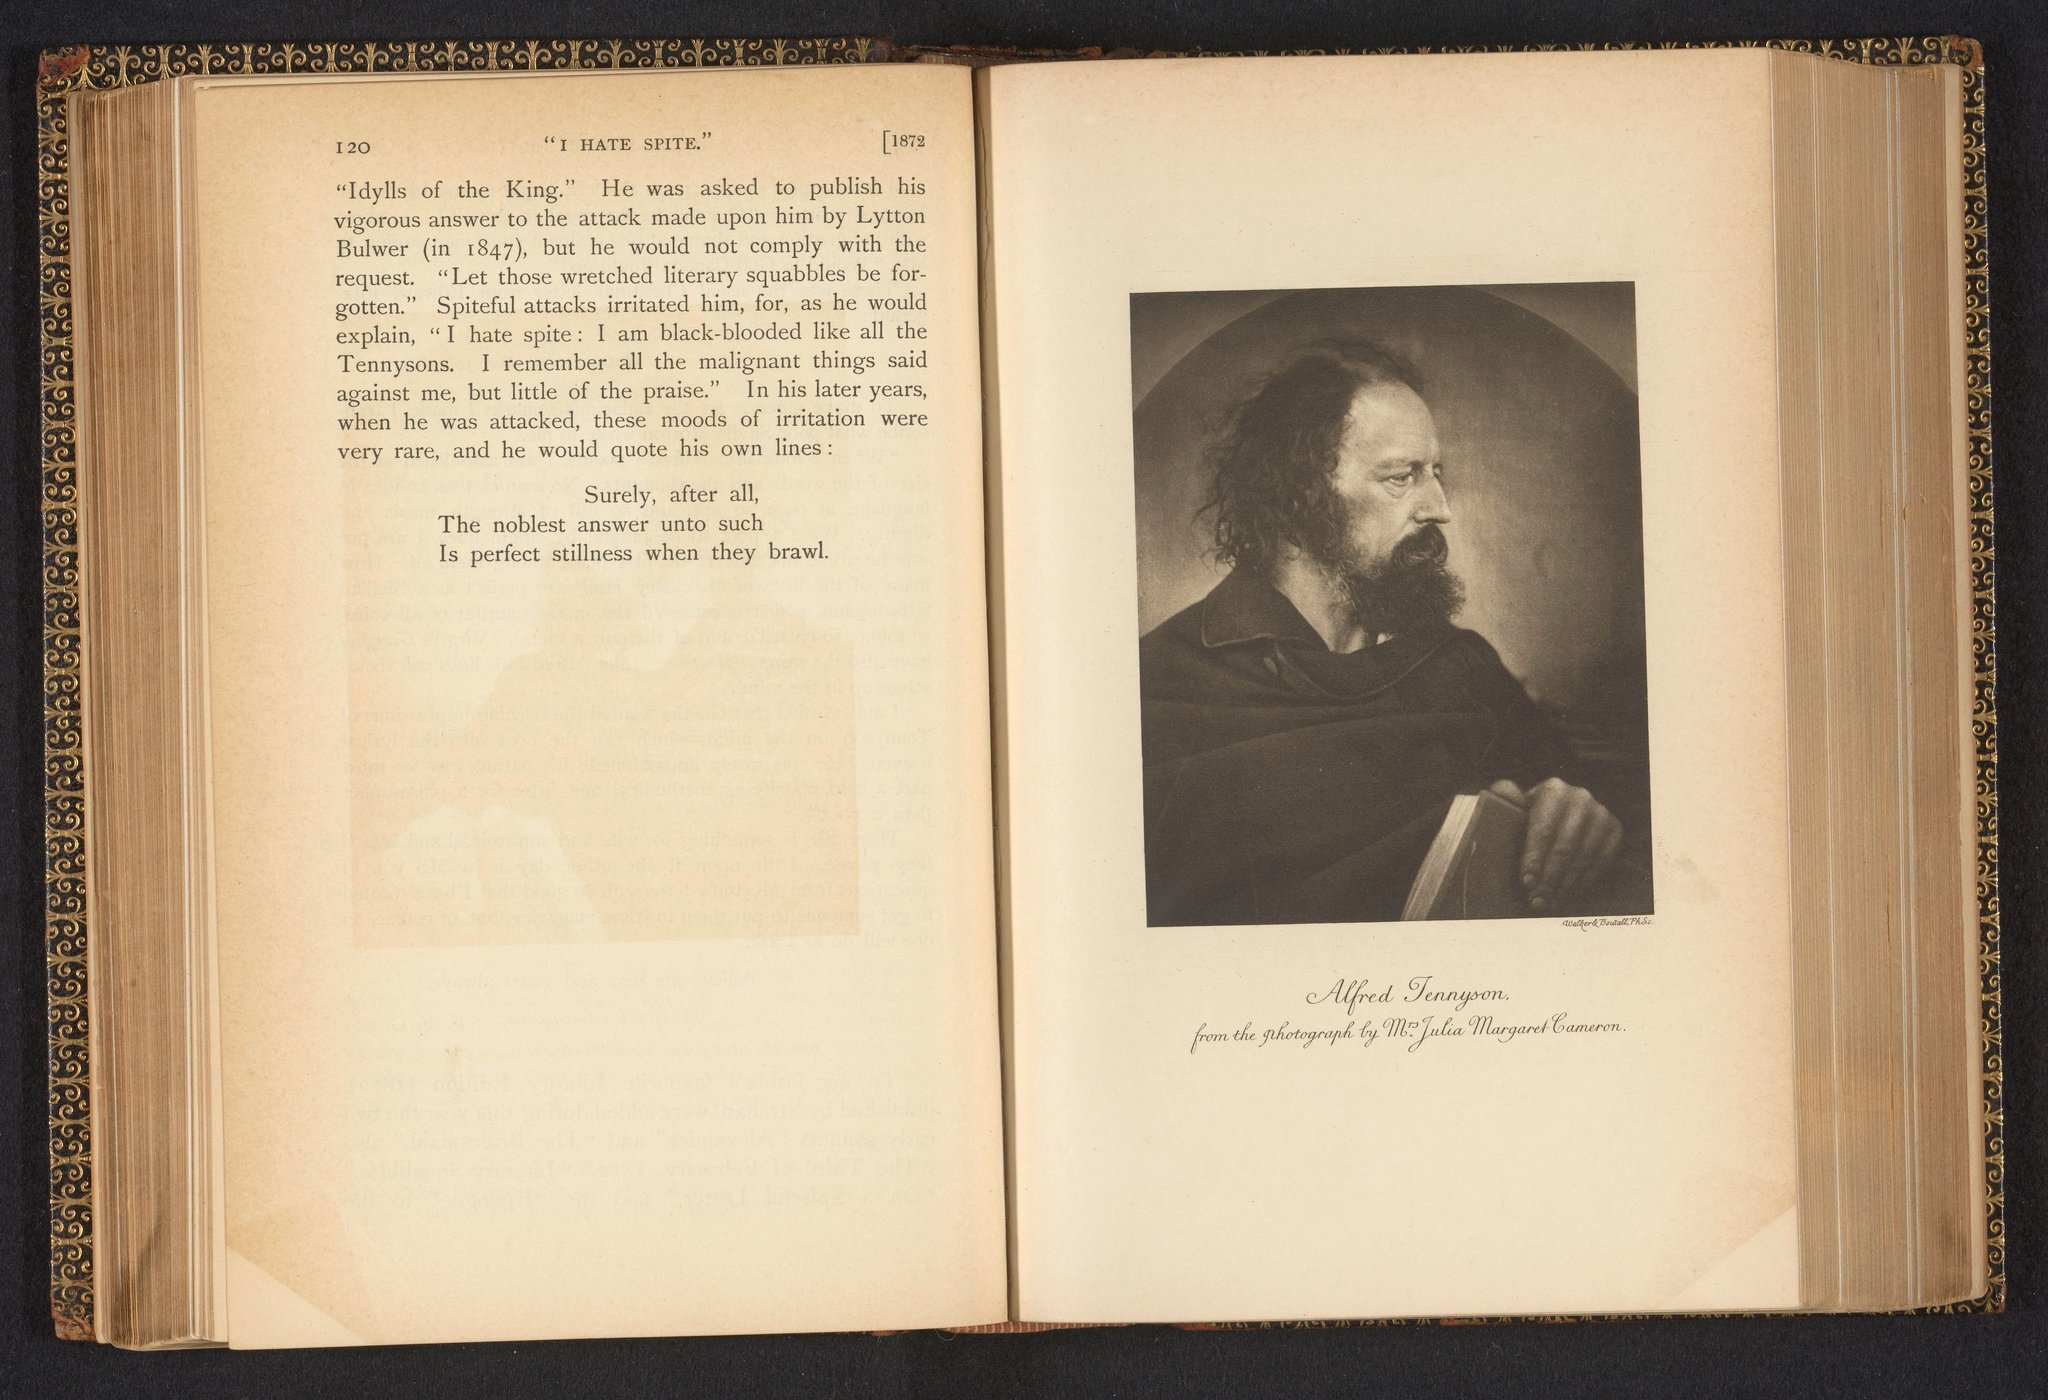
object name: photomechanical print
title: Alfred Tennyson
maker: julia margaret cameron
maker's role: fotograaf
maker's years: 1815-1879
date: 1887-1897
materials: paper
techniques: photoaquatint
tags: alfred tennyson, portrait of a writer